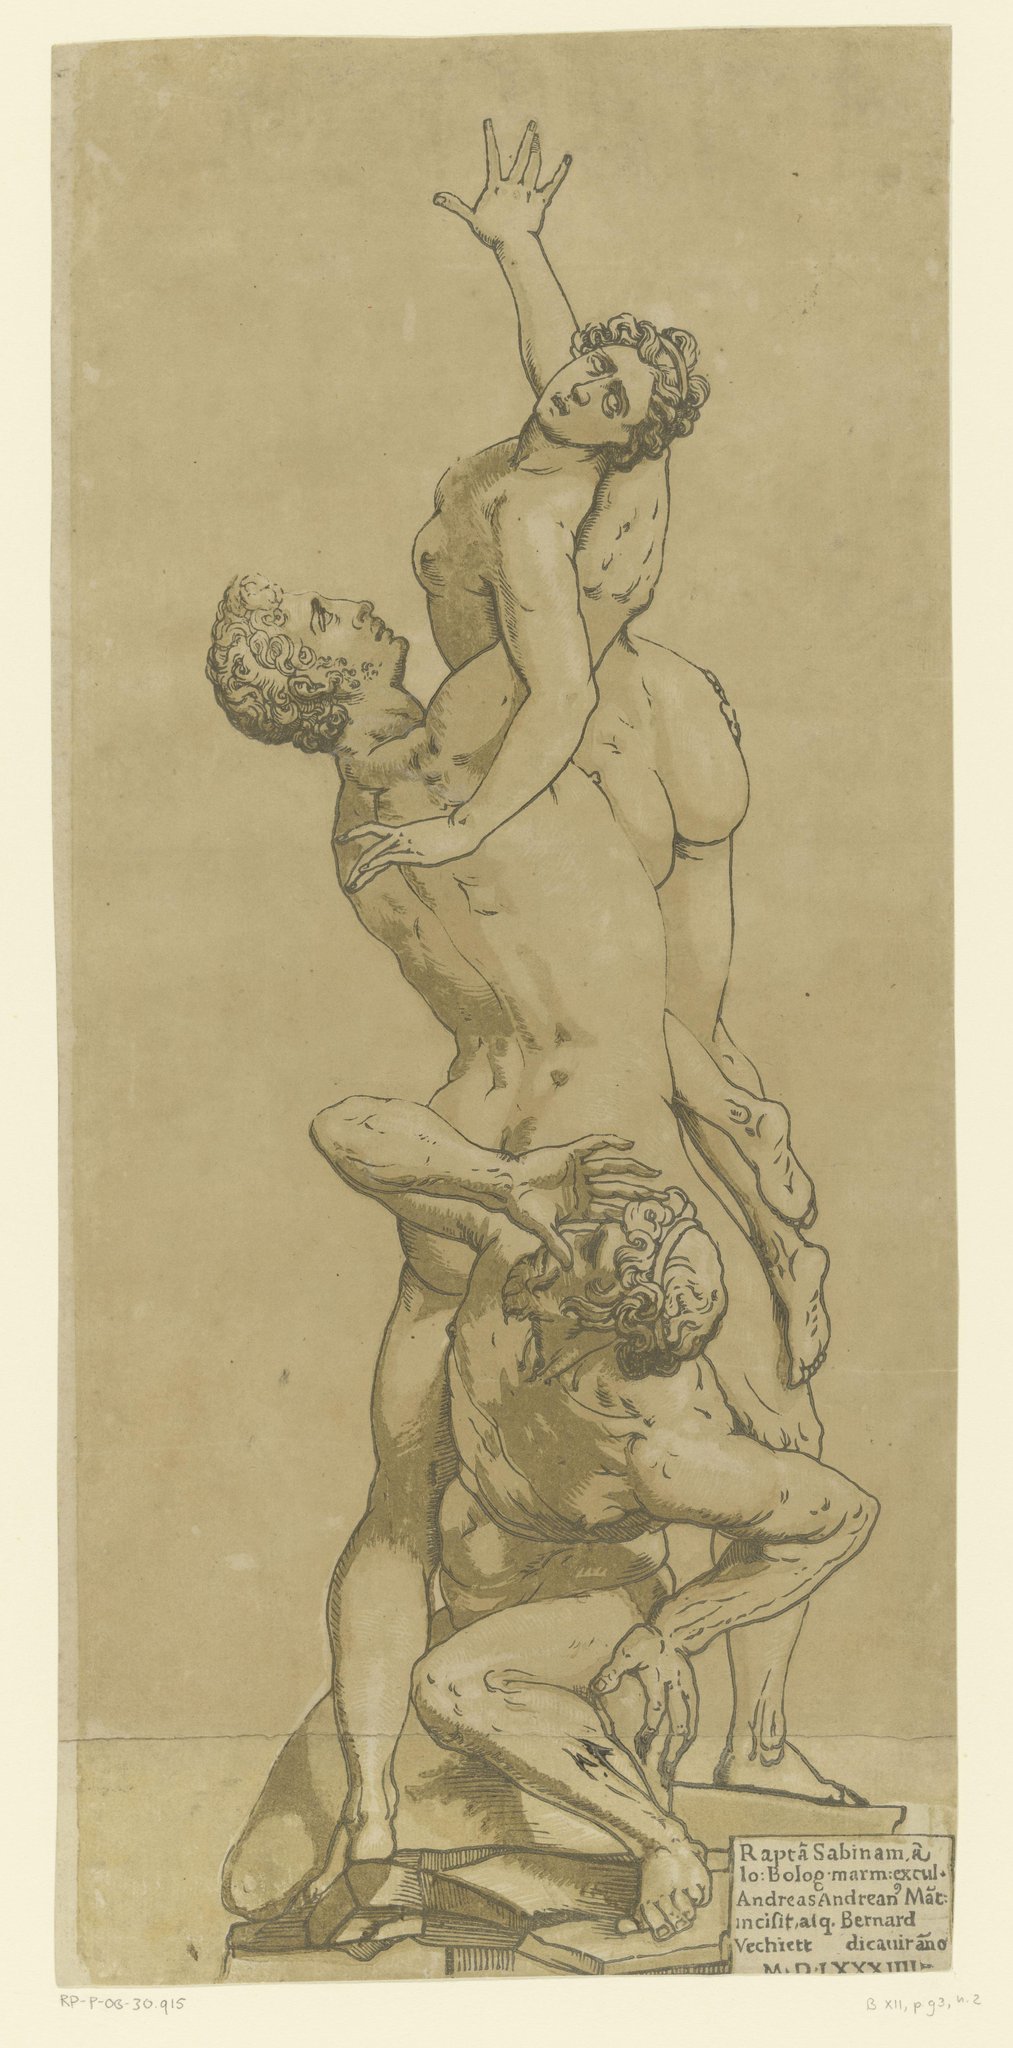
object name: print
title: Sabijnse maagdenroof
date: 1584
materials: paper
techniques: woodcut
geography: florence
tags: rape of the sabine women: they are carried off by romulus and his men during a feast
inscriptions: collector's mark: Lugt 240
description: Op een rotspartij staat een Romeinse man met in zijn armen een geroofde Sabijnse maagd. Zij wendt zich met geopende mond van hem af. Tussen de benen van de Romein hurkt een verslagen Sabijnse man.